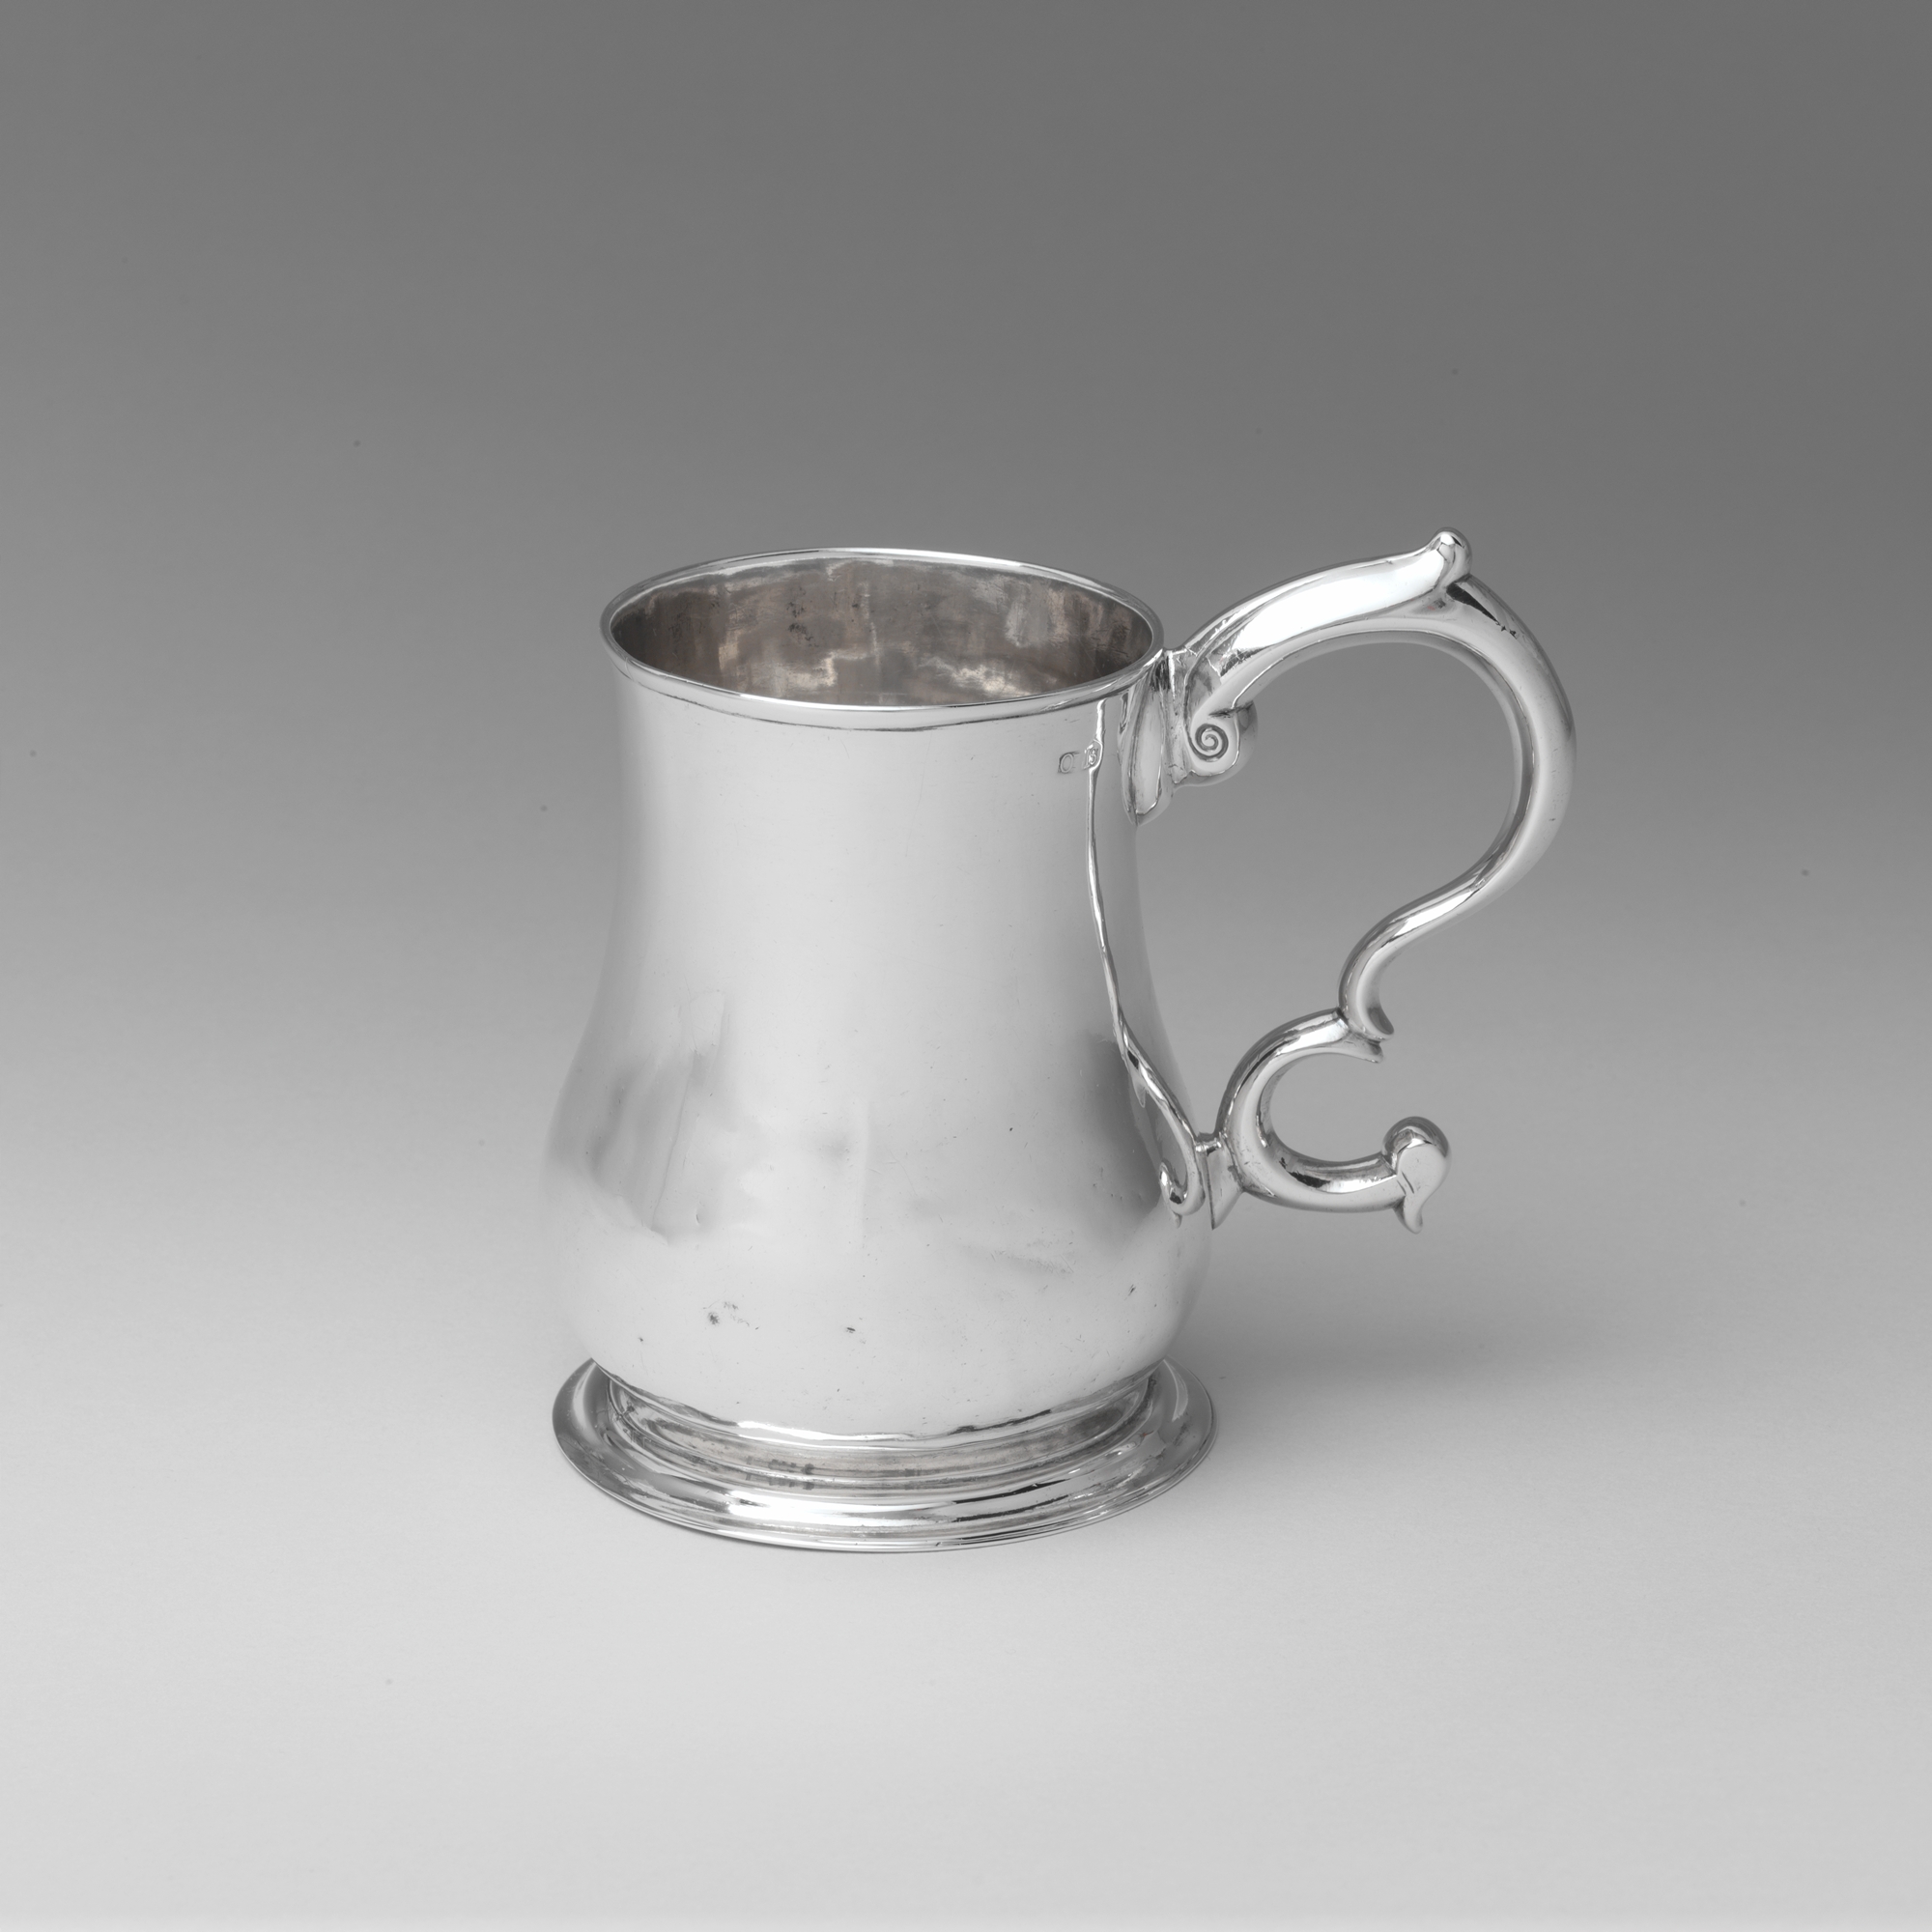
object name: cann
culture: american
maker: jonathan otis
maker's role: maker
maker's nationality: american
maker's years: 1723-1791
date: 1760-1785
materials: silver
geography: united states